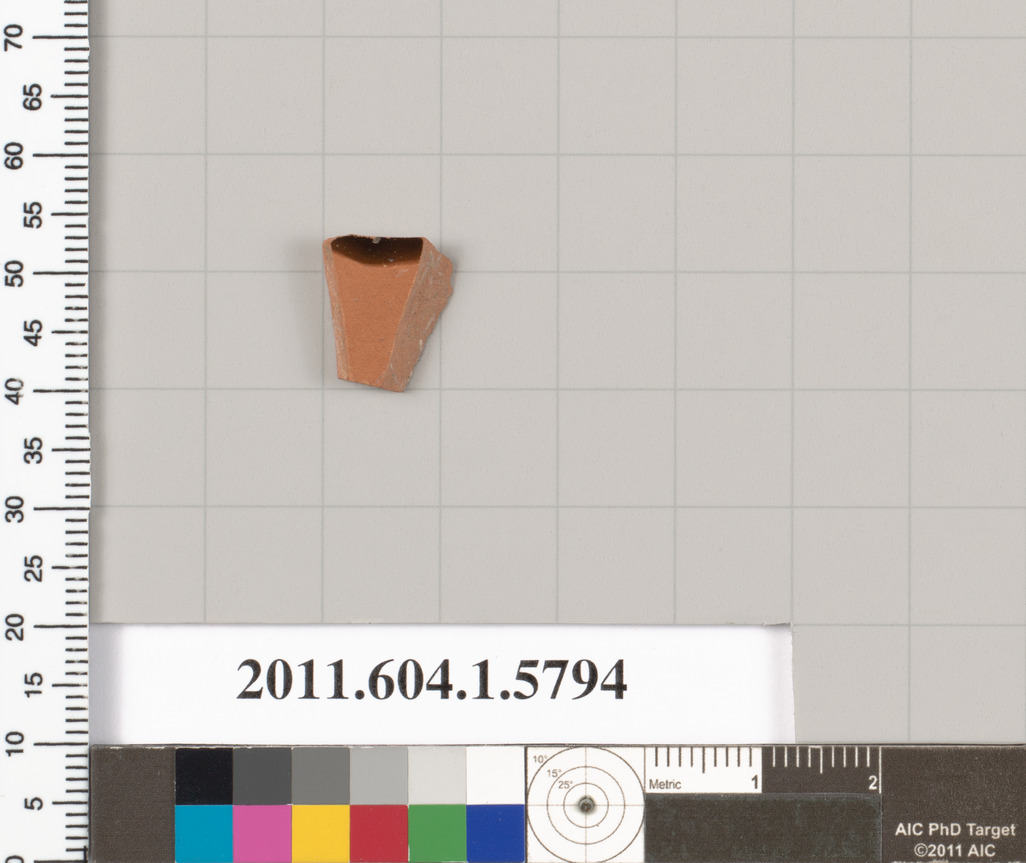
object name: kylix fragment, eye cup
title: Terracotta fragment of a kylix: eye-cup (drinking cup)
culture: greek, attic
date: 525-510 BCE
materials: terracotta